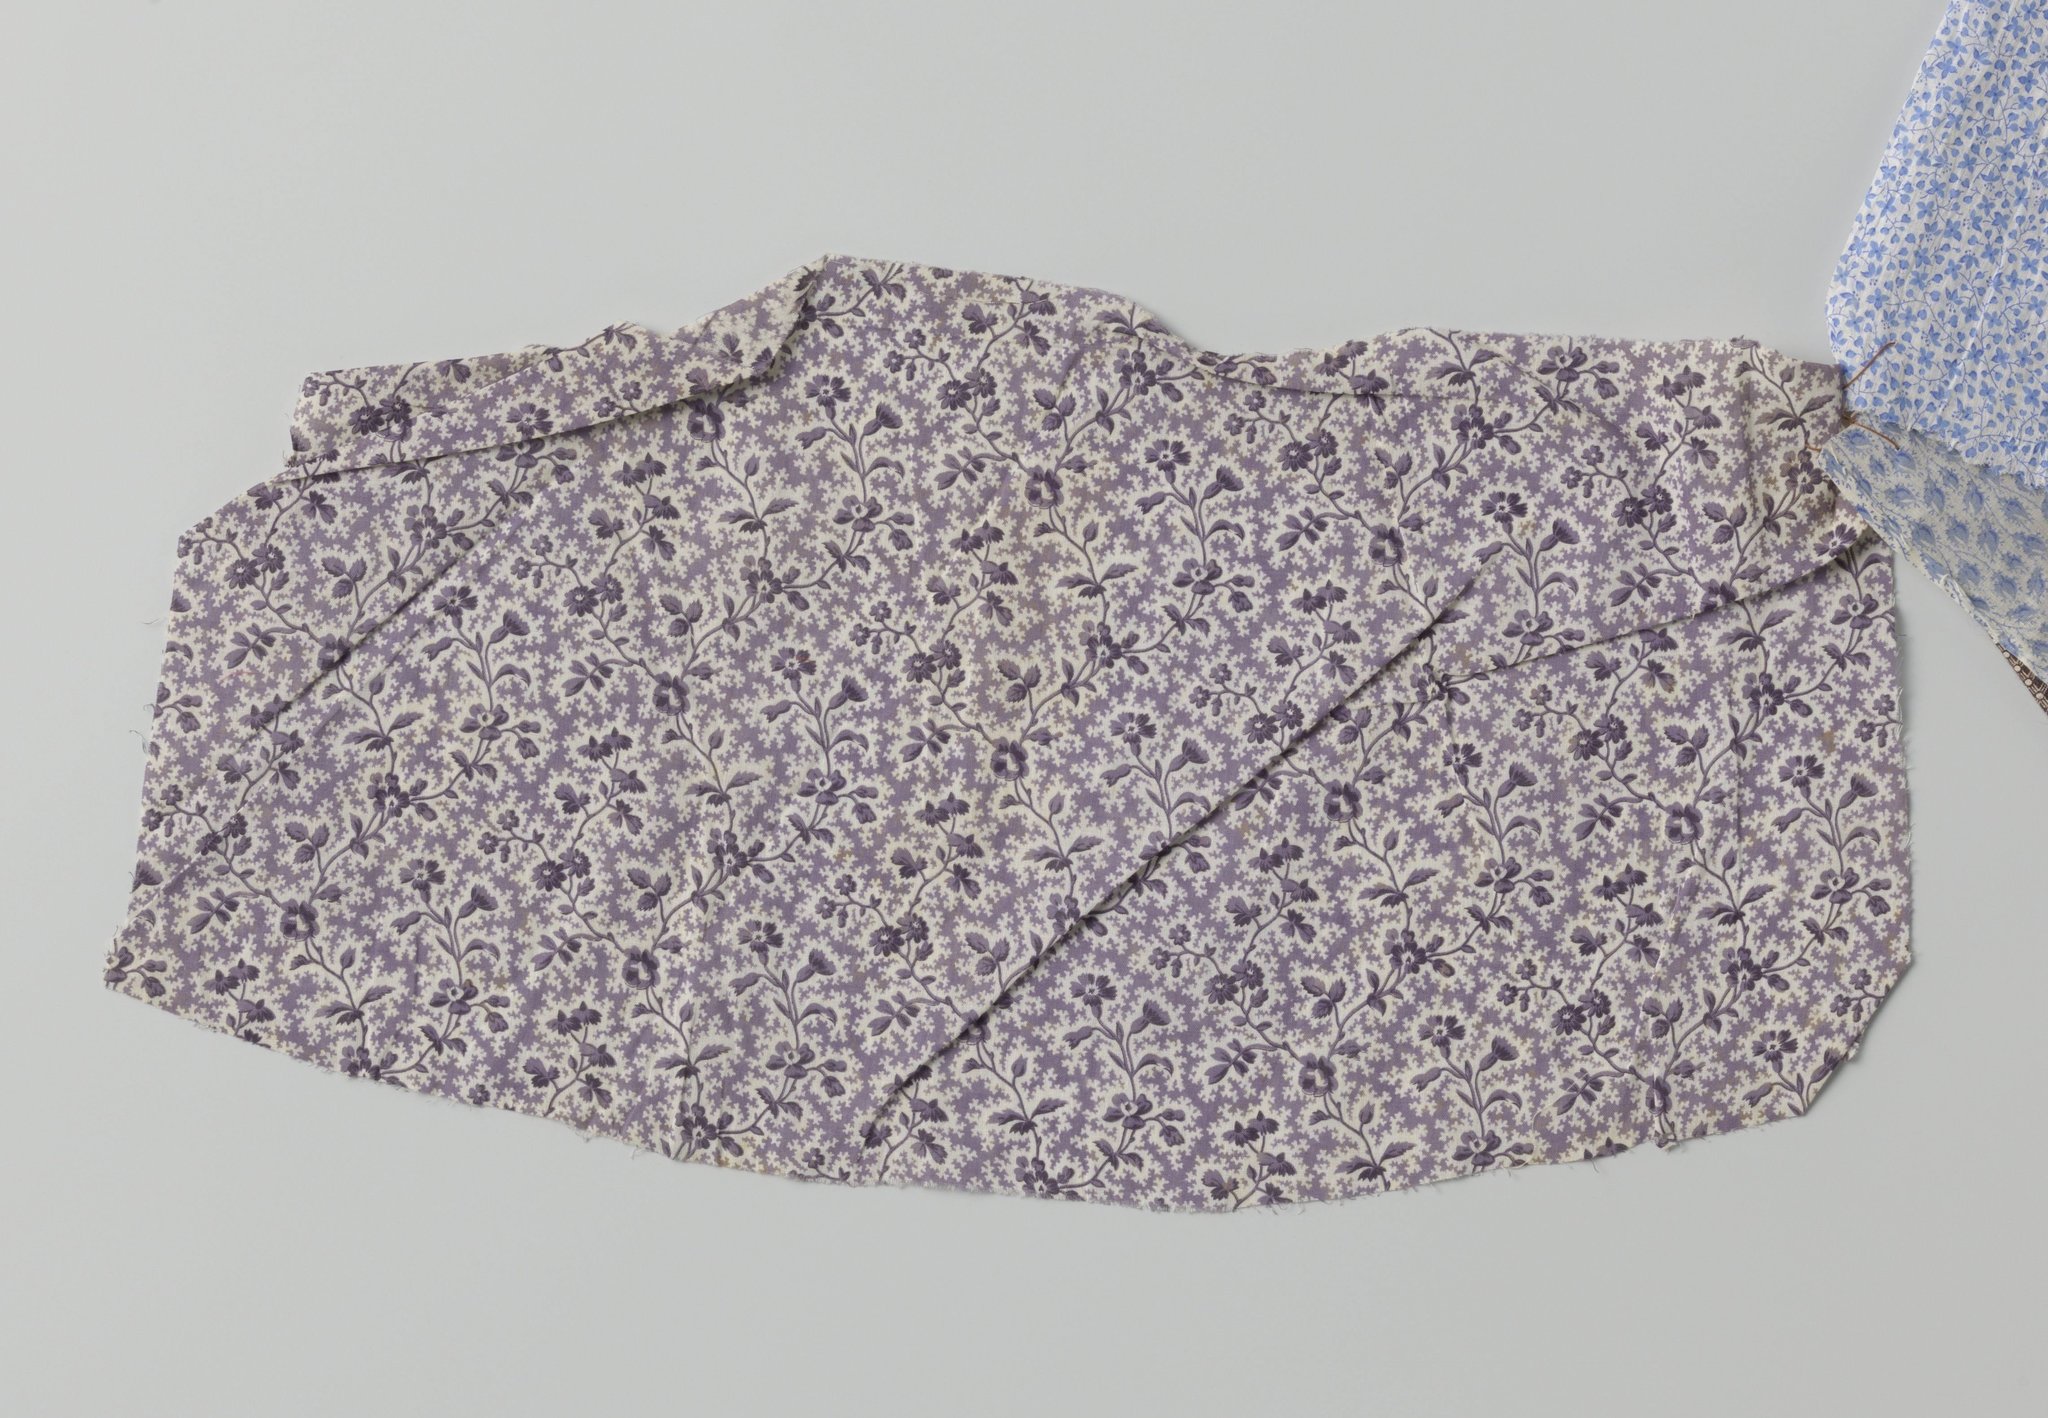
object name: fragment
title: Fragment van een bedrukte katoen met bloemranken en onregelmatige vlekken in paars op witte grond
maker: Anonymous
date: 1920-1950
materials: cotton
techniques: printing, weave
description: Fragment van bedrukte katoen. Op de witte katoen zijn paarse bloemenranken gedrukt waartussen paarse onregelmatige vlekpatronen.